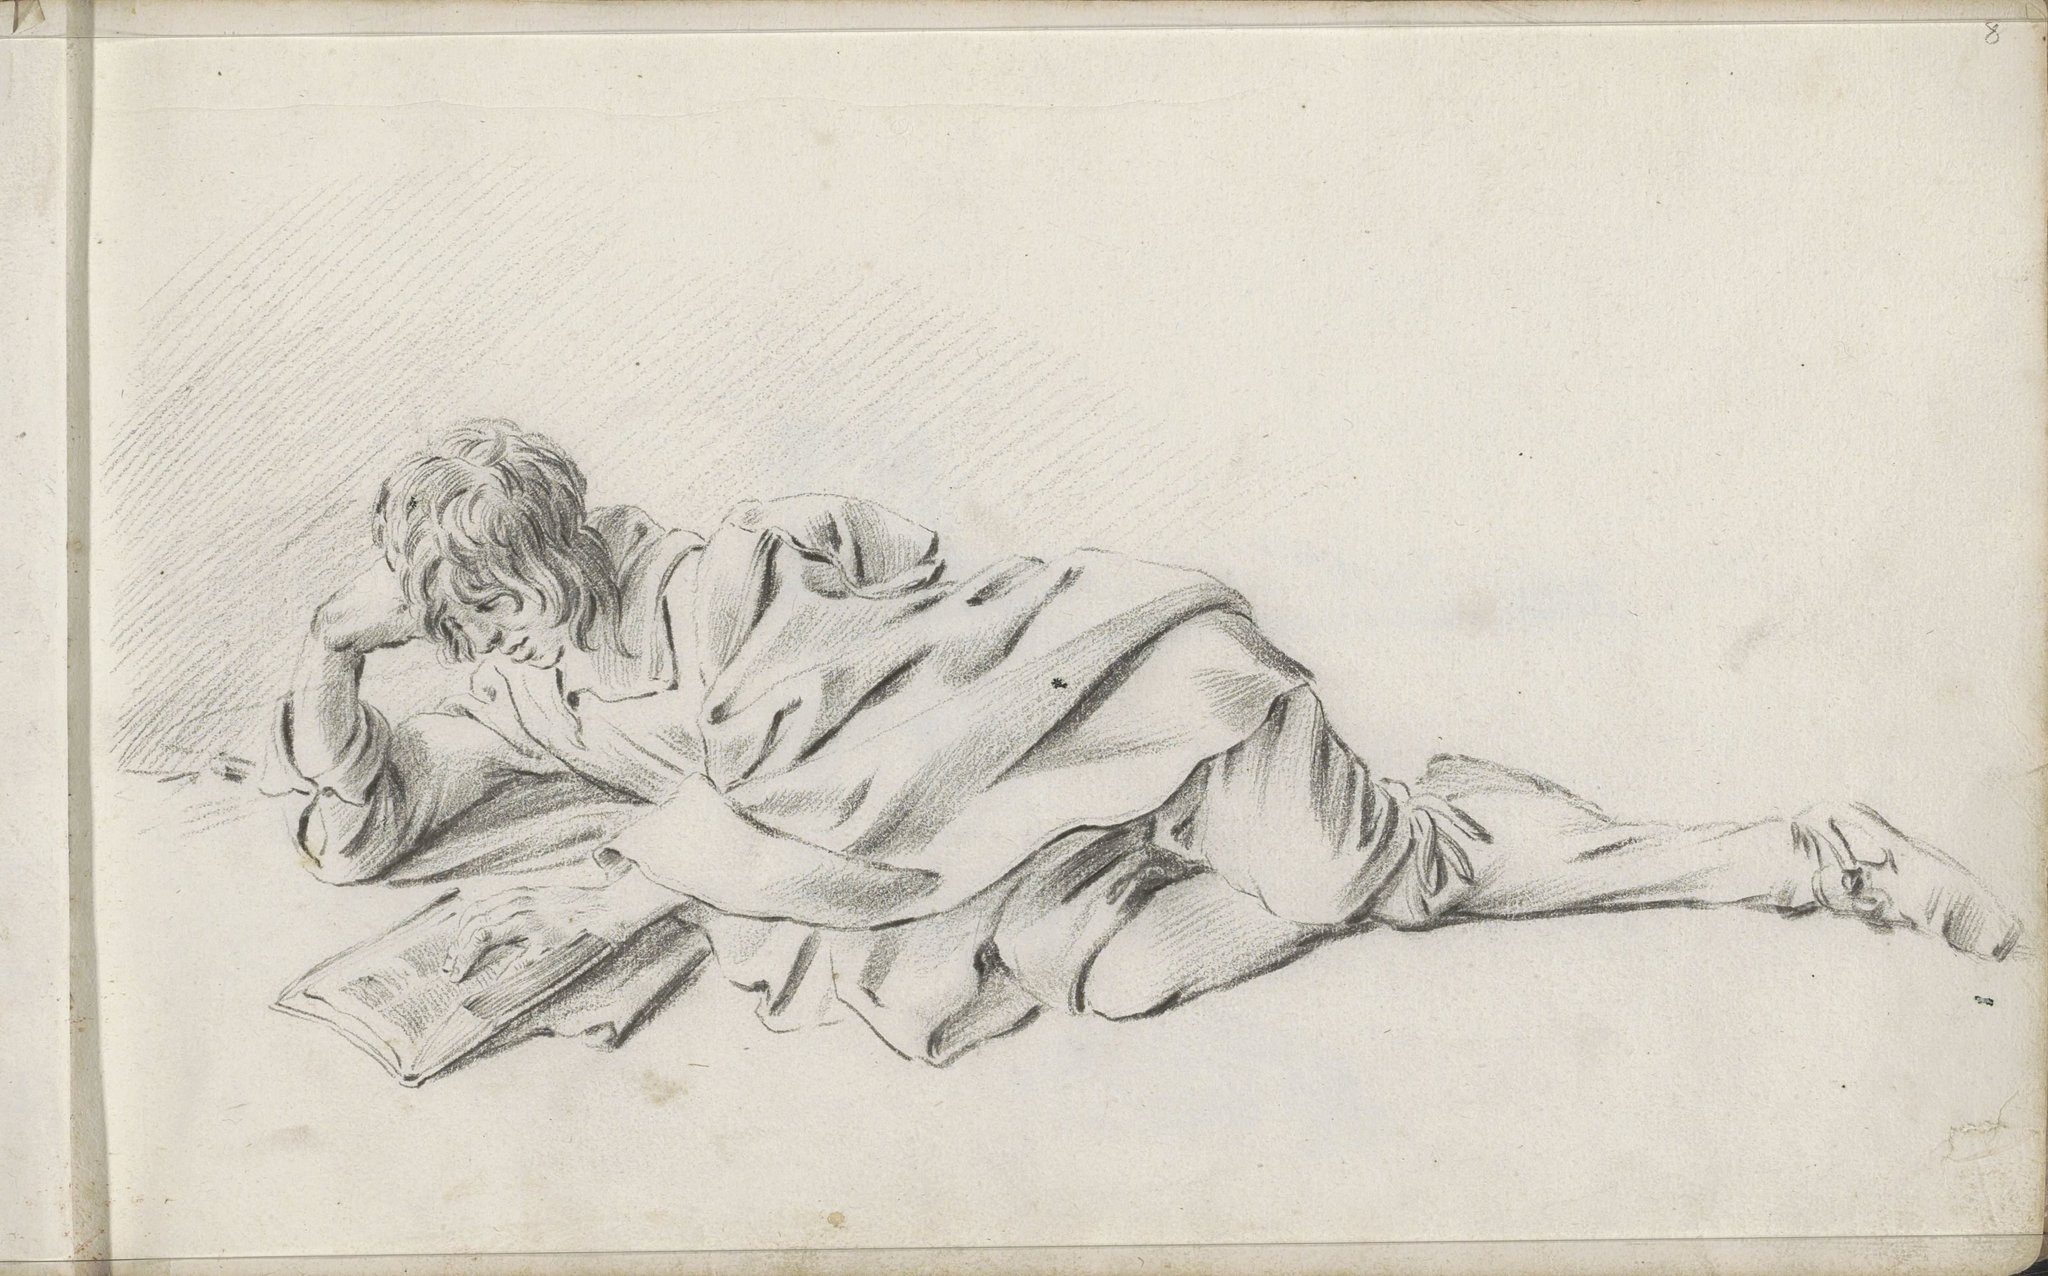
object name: sketchbook leaf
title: Liggende jongen lezend in een boek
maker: pieter moninckx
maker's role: draughtsman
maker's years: 1606-1686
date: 1645-1646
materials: chalk, paper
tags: reading, lying on one side, with uplifted upper part of the body and leaning on the arm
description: Blad 8 recto uit een schetsboek met 39 bladen.